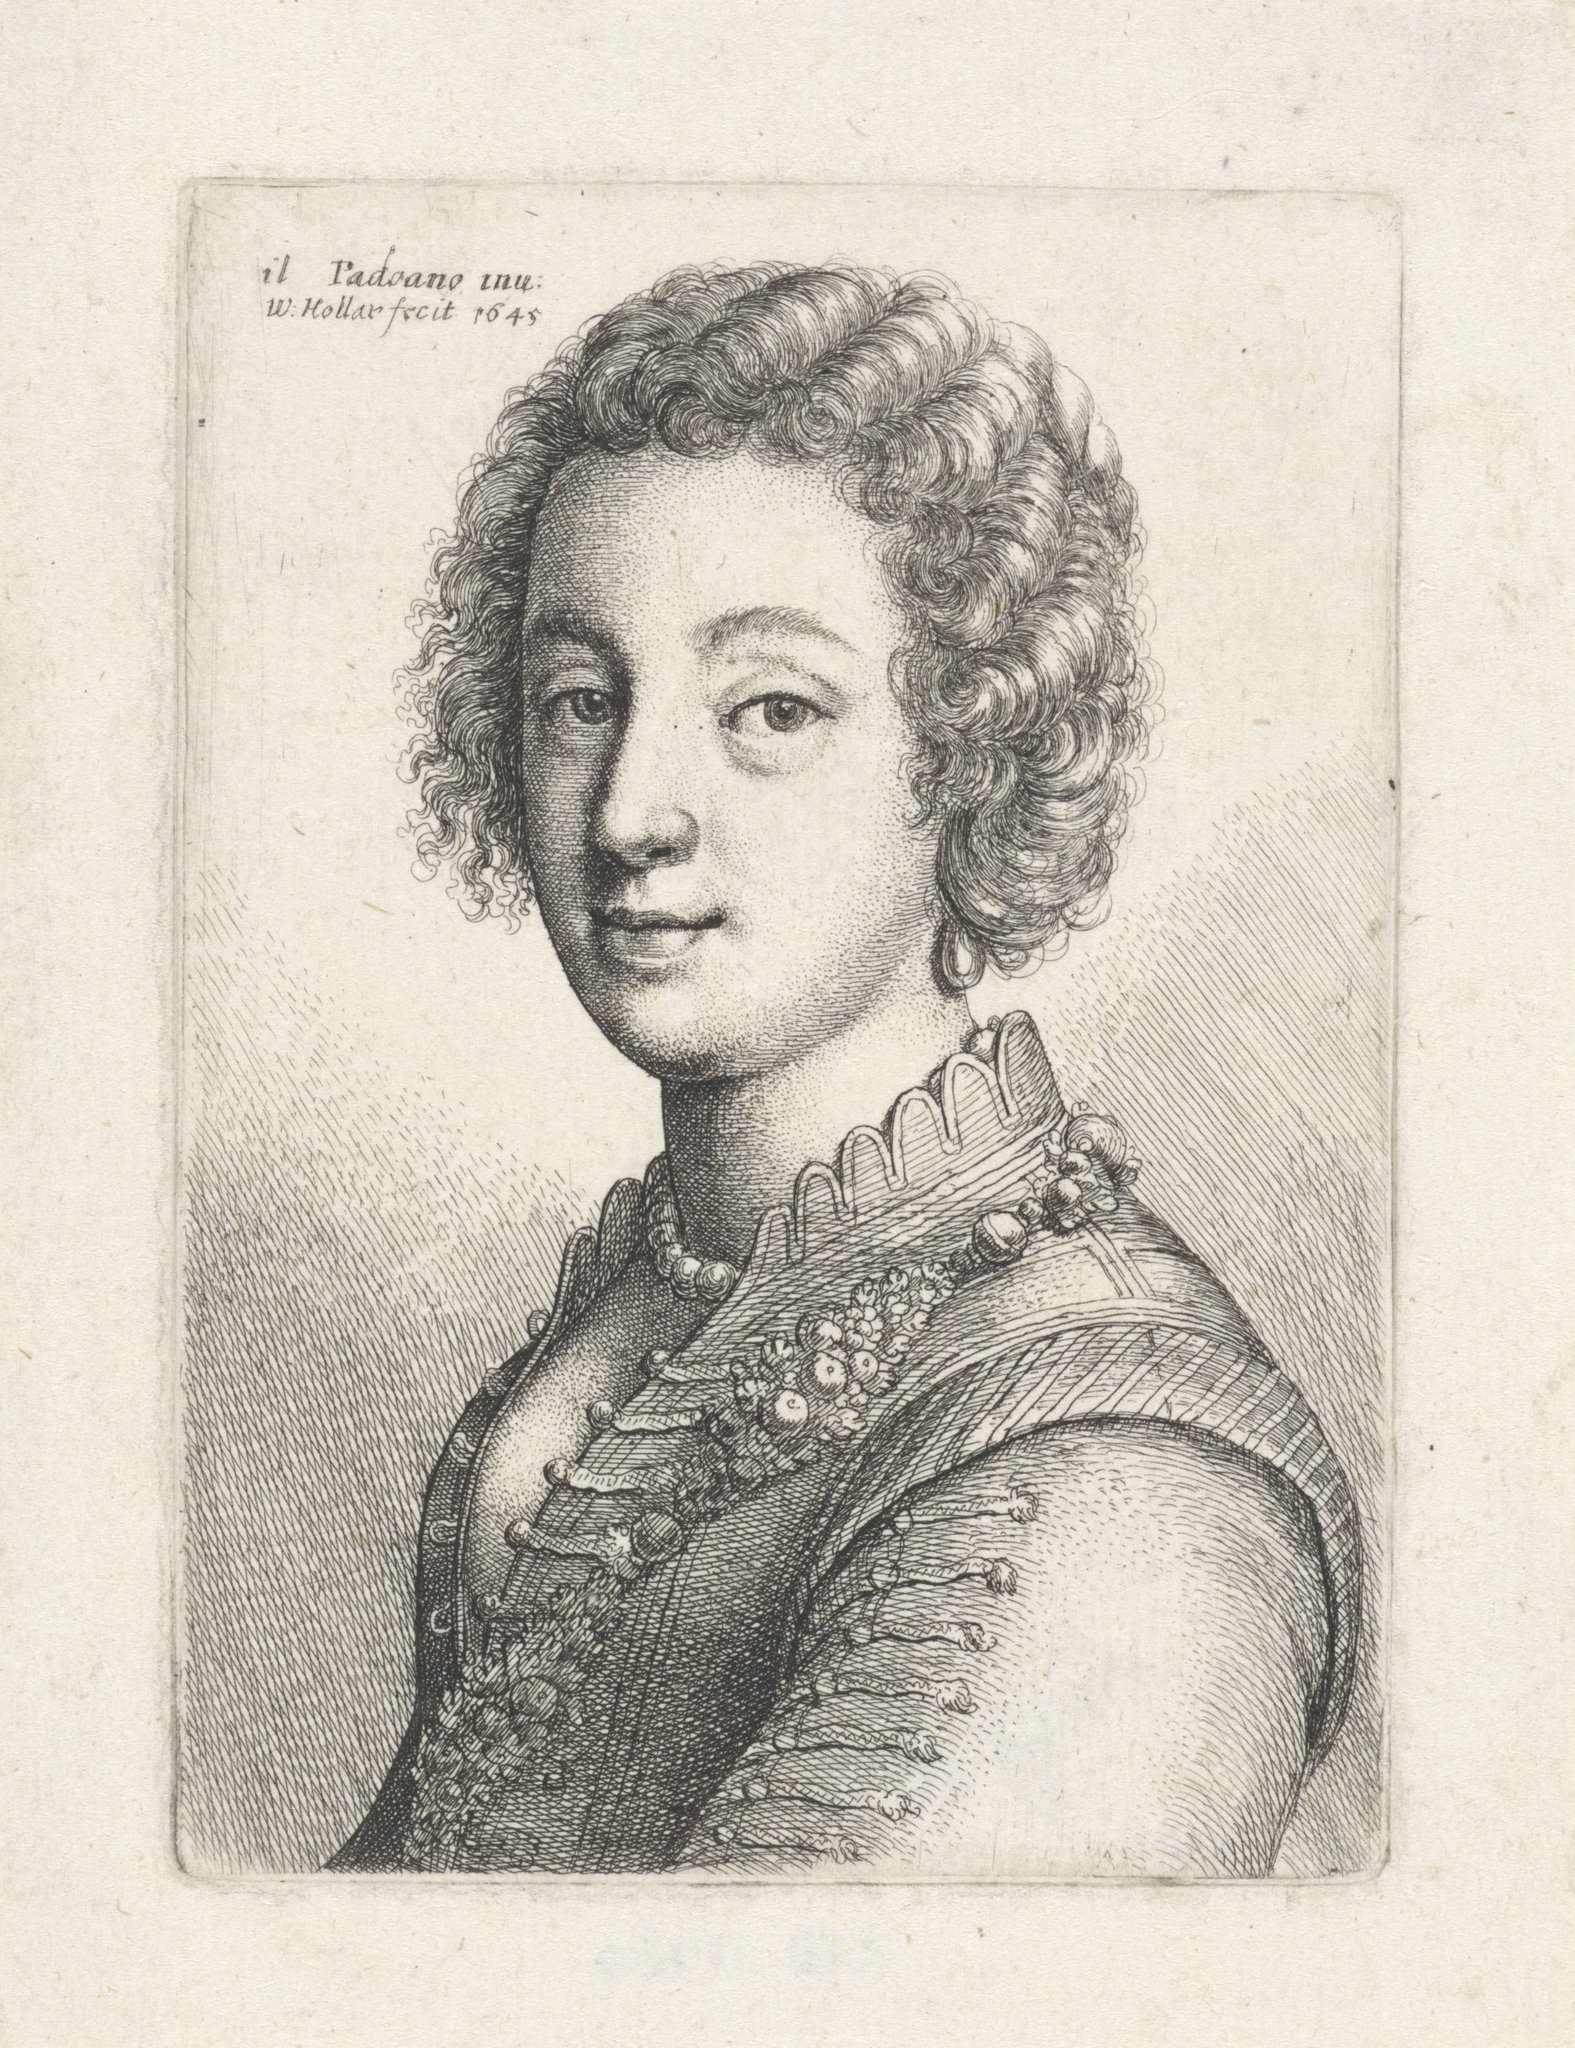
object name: print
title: Portret van jonge vrouw met kort krullend haar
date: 1645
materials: paper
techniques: etching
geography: antwerp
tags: anonymous historical person portrayed alone - bb - woman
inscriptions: collector's mark: Lugt 240